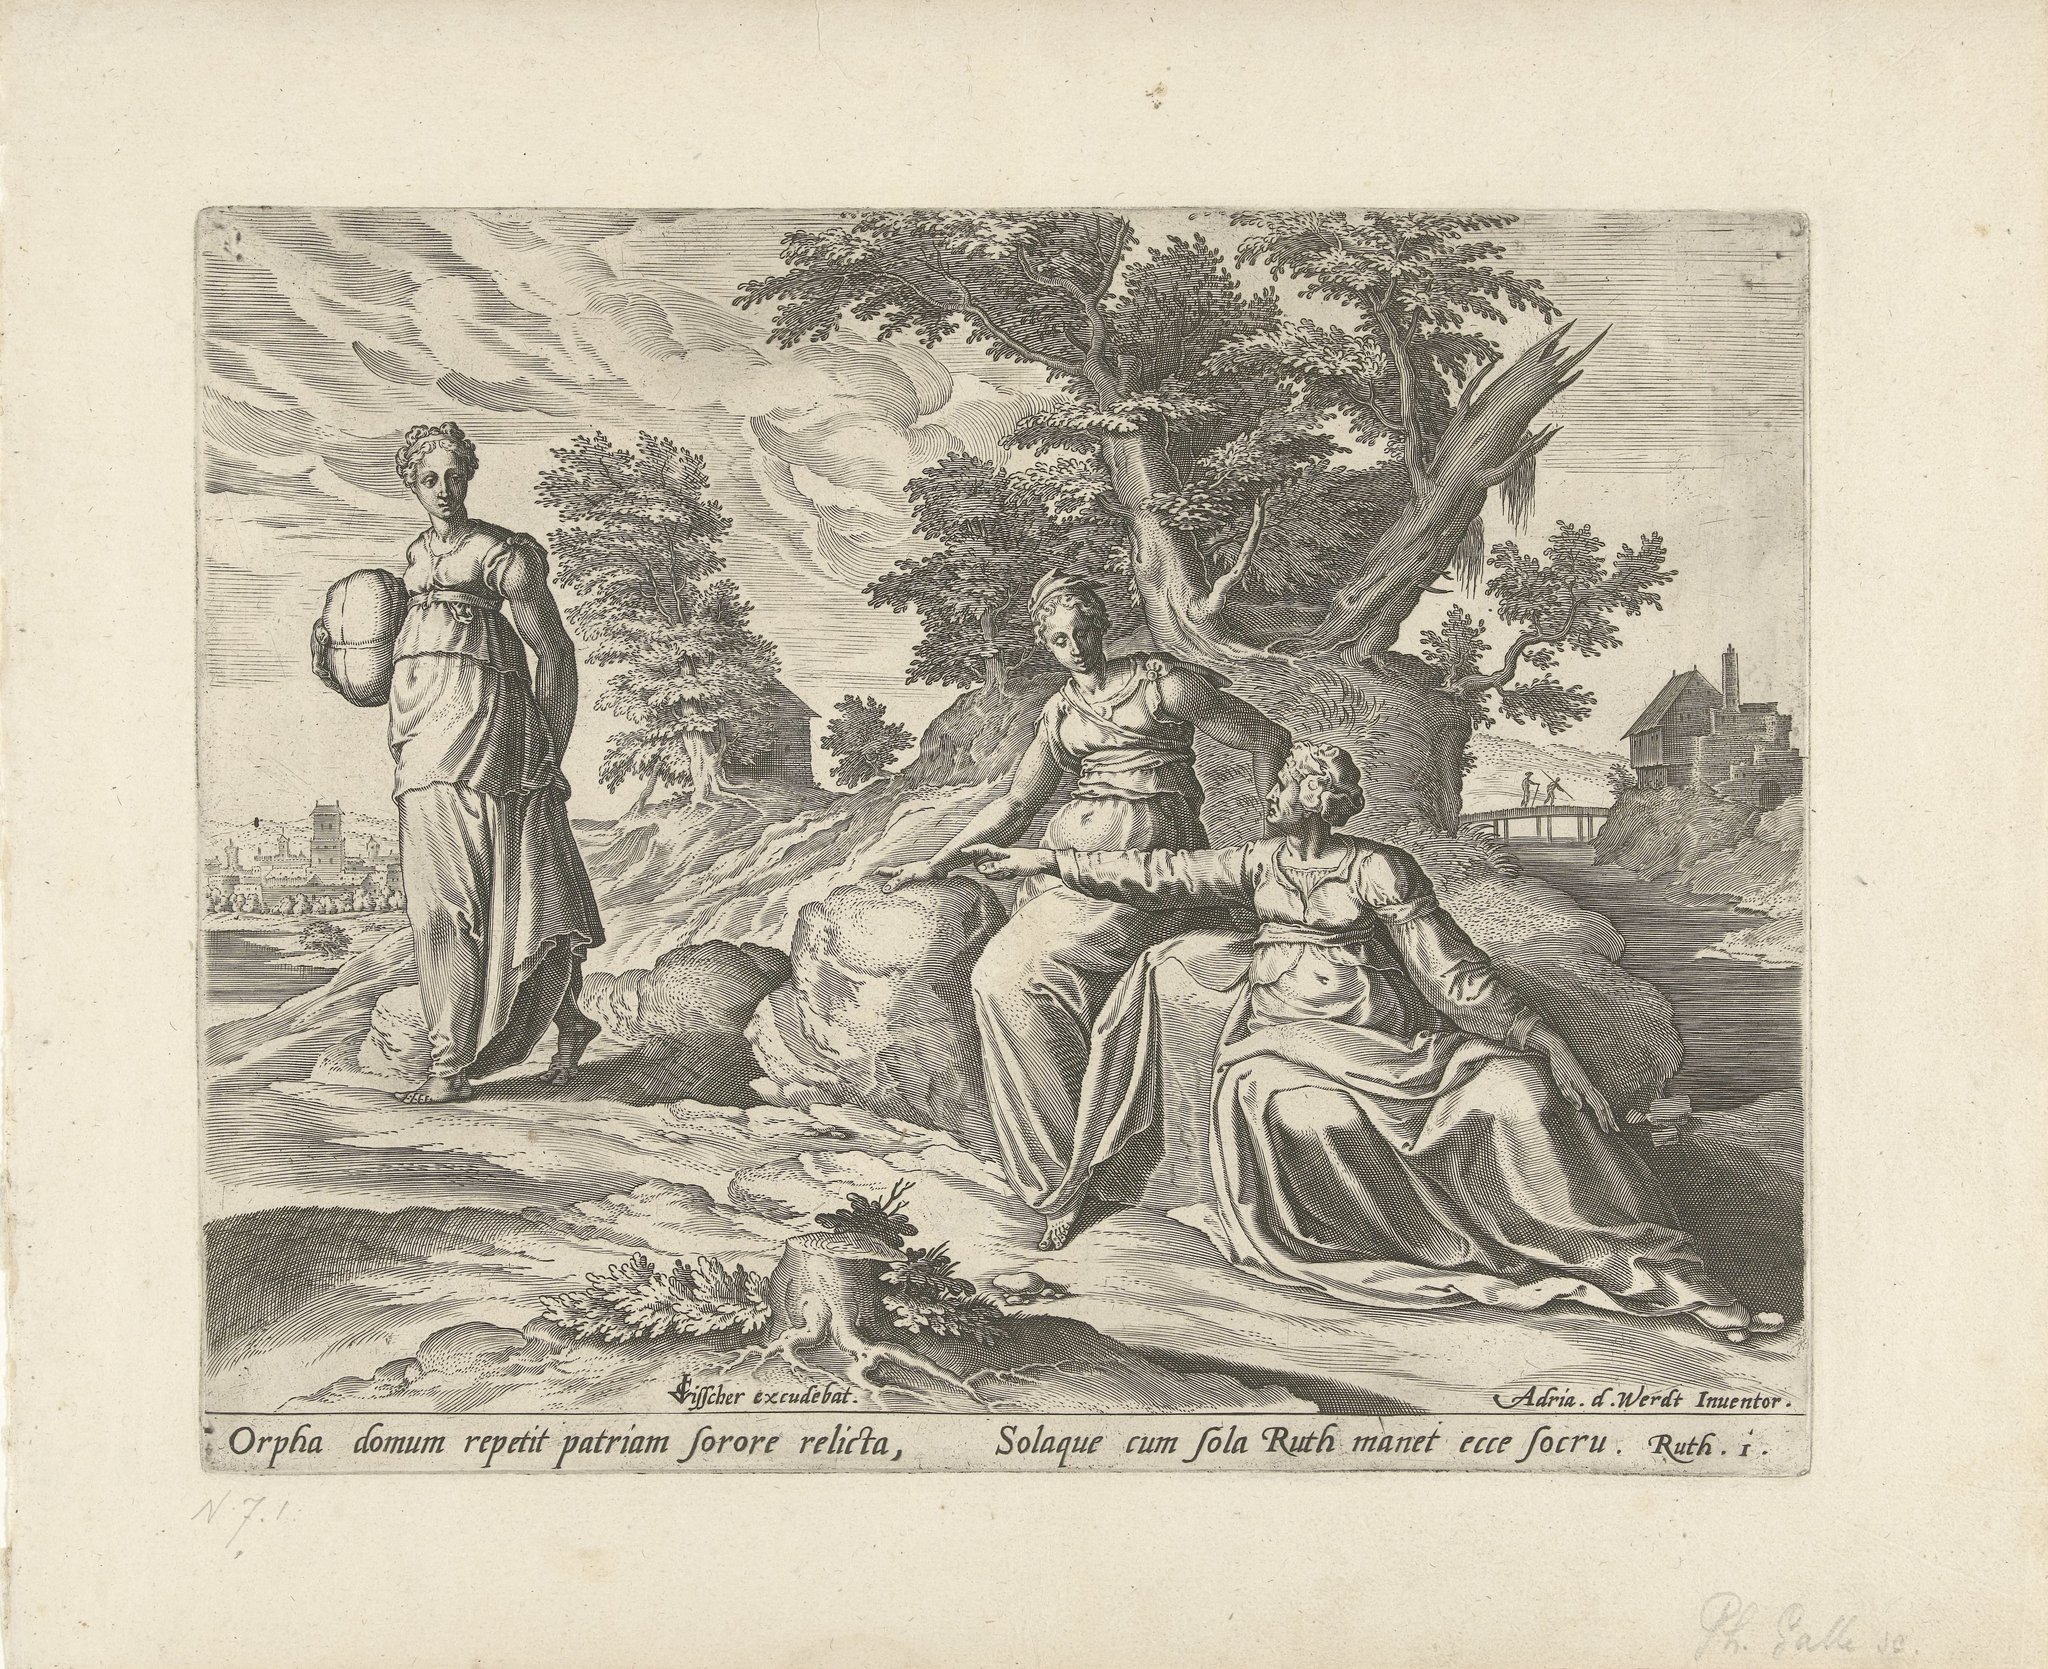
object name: print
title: Orpa verlaat Ruth en Naomi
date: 1600-1652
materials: paper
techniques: engraving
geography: haarlem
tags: naomi sends away her daughters-in-law: orpah returns home, ruth stays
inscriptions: collector's mark: Lugt 2228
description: Ruth is met haar twee schoondochters op weg naar Juda. Onderweg stuurt ze de vrouwen terug naar hun ouderlijk huis. Orpa vertrekt, maar Ruth blijft bij Naomi. Ruth en Naomi zitten op stenen aan de oever van een rivier. Orpa staat met haar pak een paar meter bij hun vandaan.